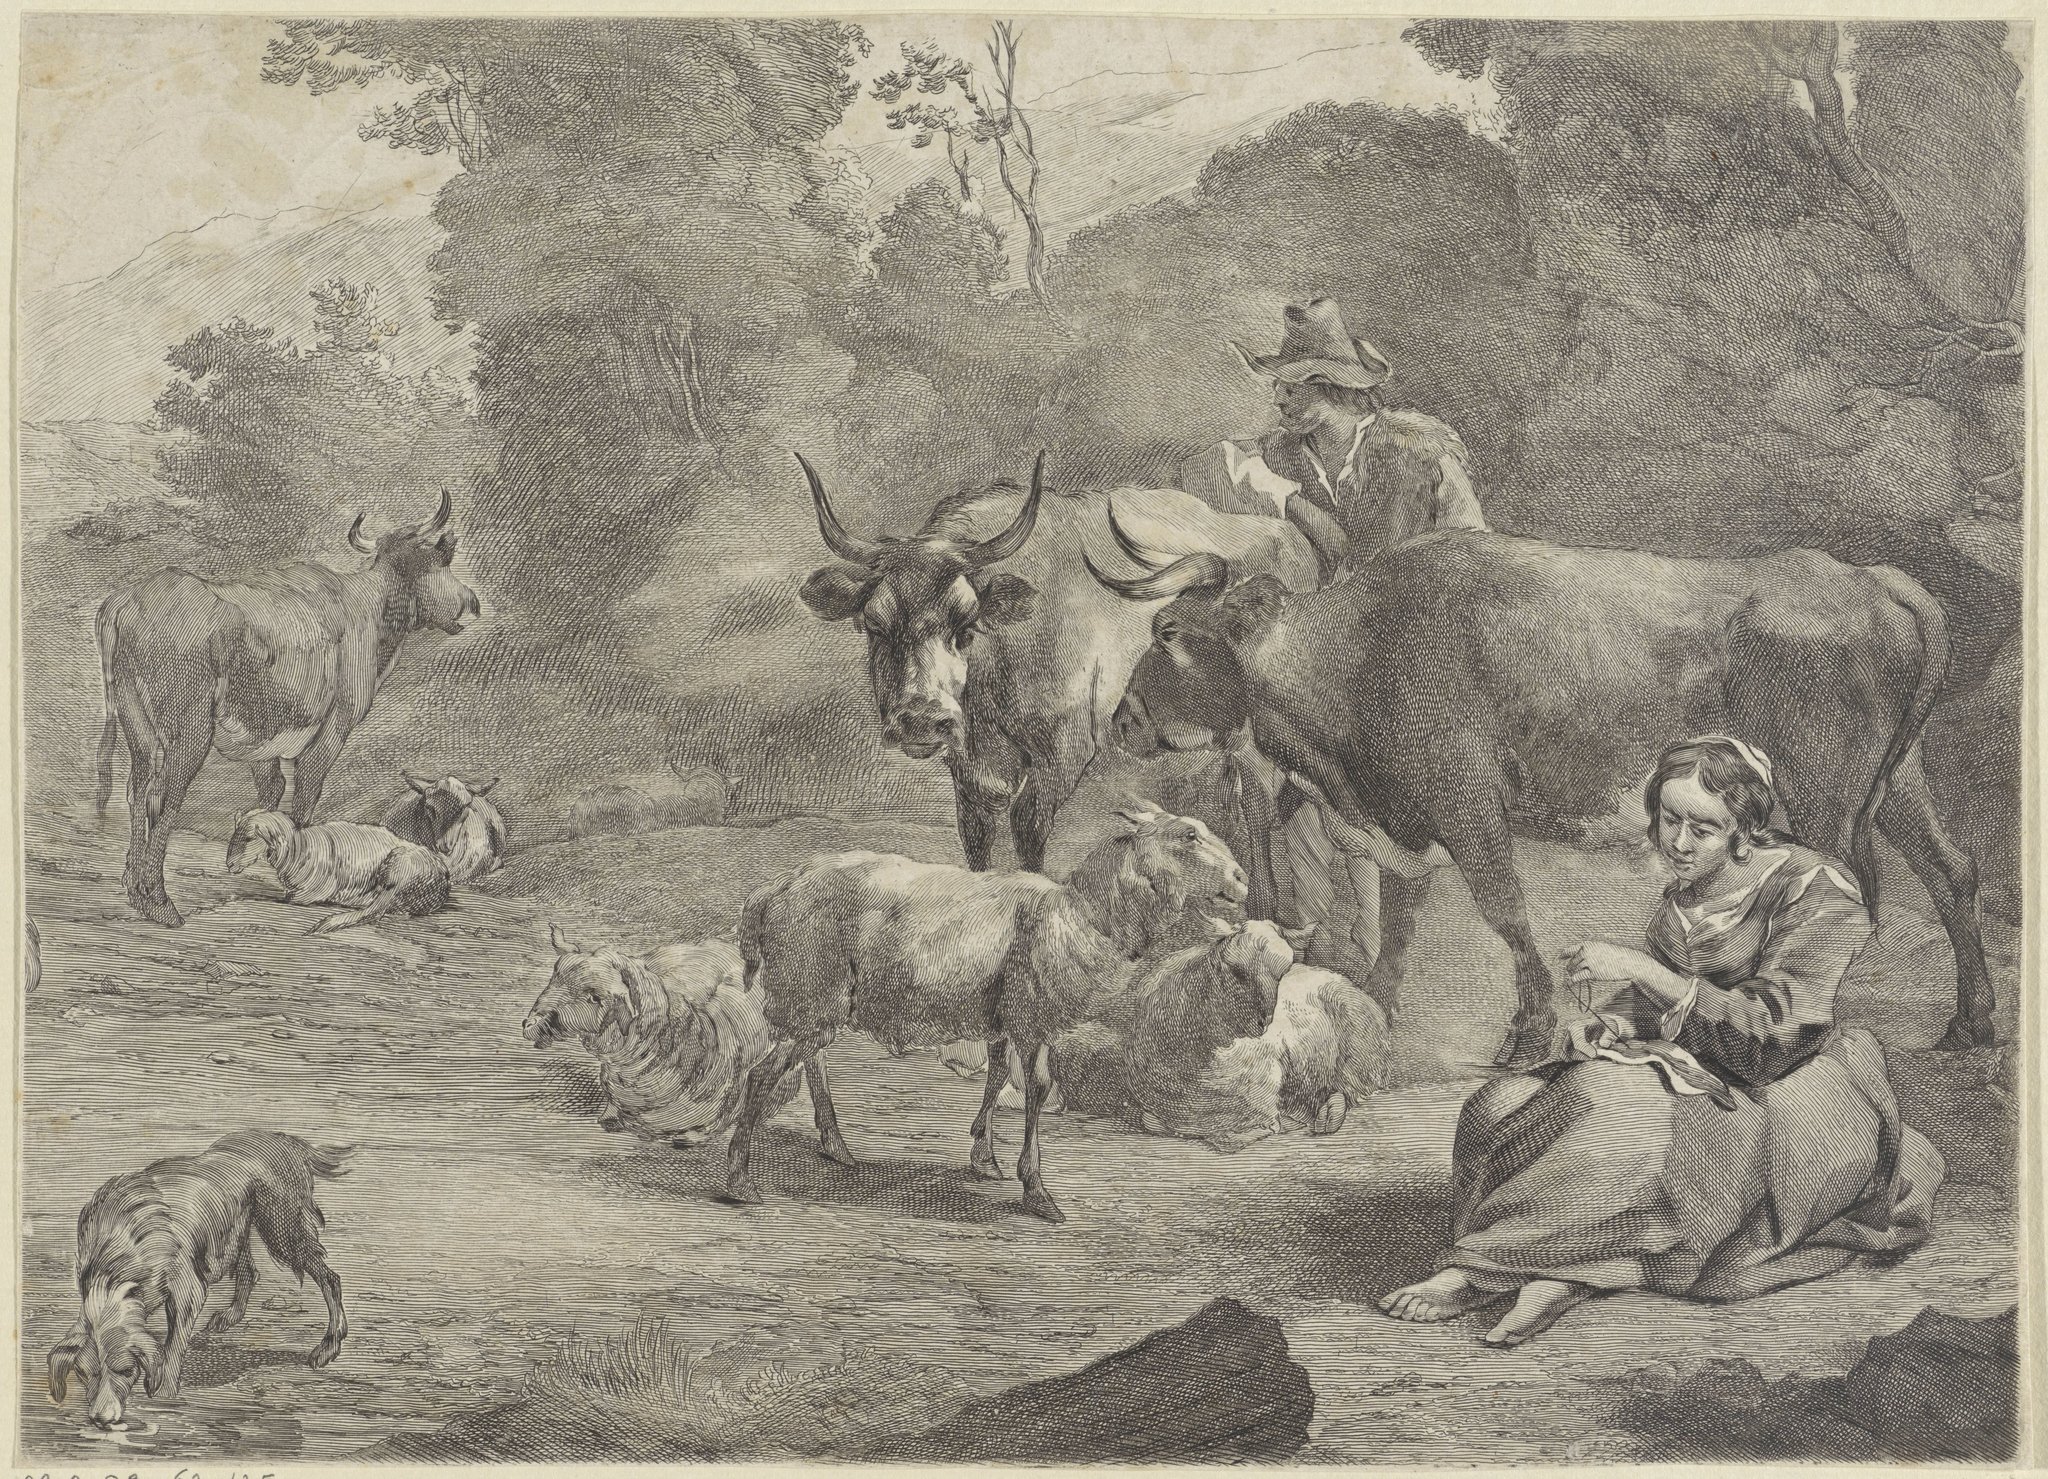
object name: print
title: Landschap met een herder en een naaiende herderin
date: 1638-1658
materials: paper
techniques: engraving, etching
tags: cow, herding, herdsman, herdswoman, shepherd, shepherdess, cowherd, etc., sheep, sewing, dog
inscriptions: collector's mark: Lugt 240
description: In een landschap voor een bomenrand zit een herderin iets te verstellen tussen de schapen en koeien. Schuin achter haar staat een herder die zijn kudde in de gaten houdt. Hij draagt een hoed en leunt op een van zijn koeien. Links drinkt een hond water uit een plas.